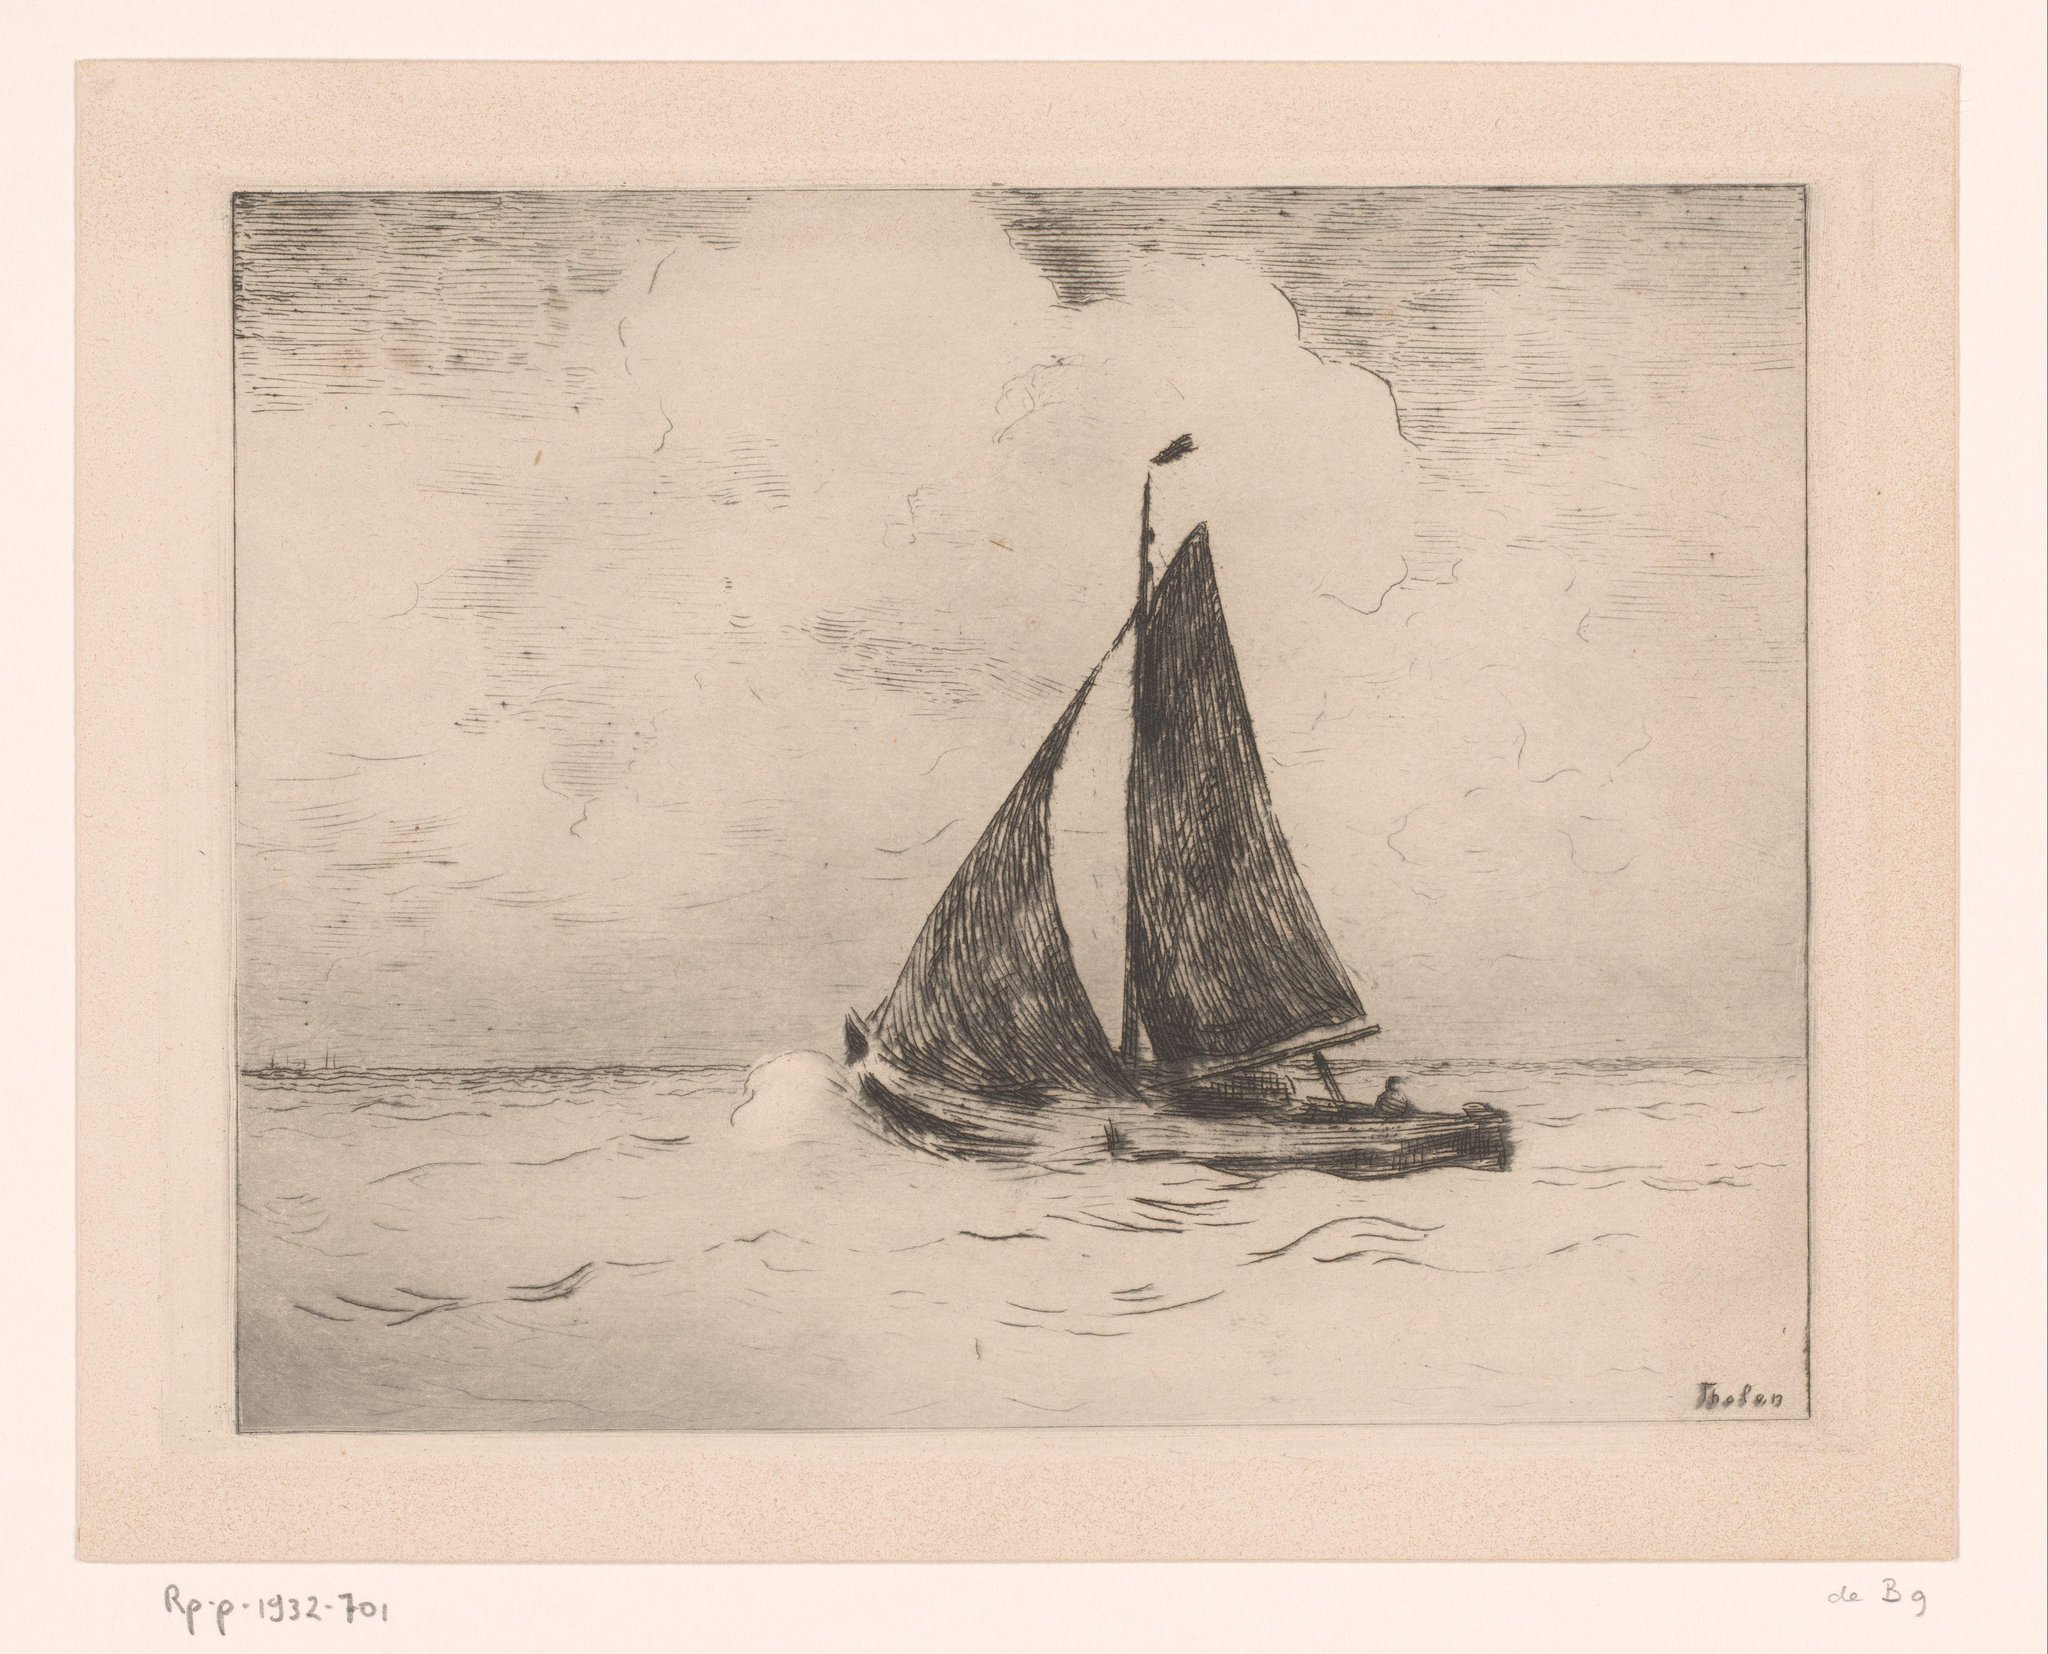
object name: print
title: Zeilboot op open water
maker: willem bastiaan tholen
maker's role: draughtsman, painter, print maker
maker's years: 1860-1931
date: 1870-1931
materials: paper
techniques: etching, intaglio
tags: sailing-ship, sailing-boat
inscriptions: collector's mark: Lugt 2228